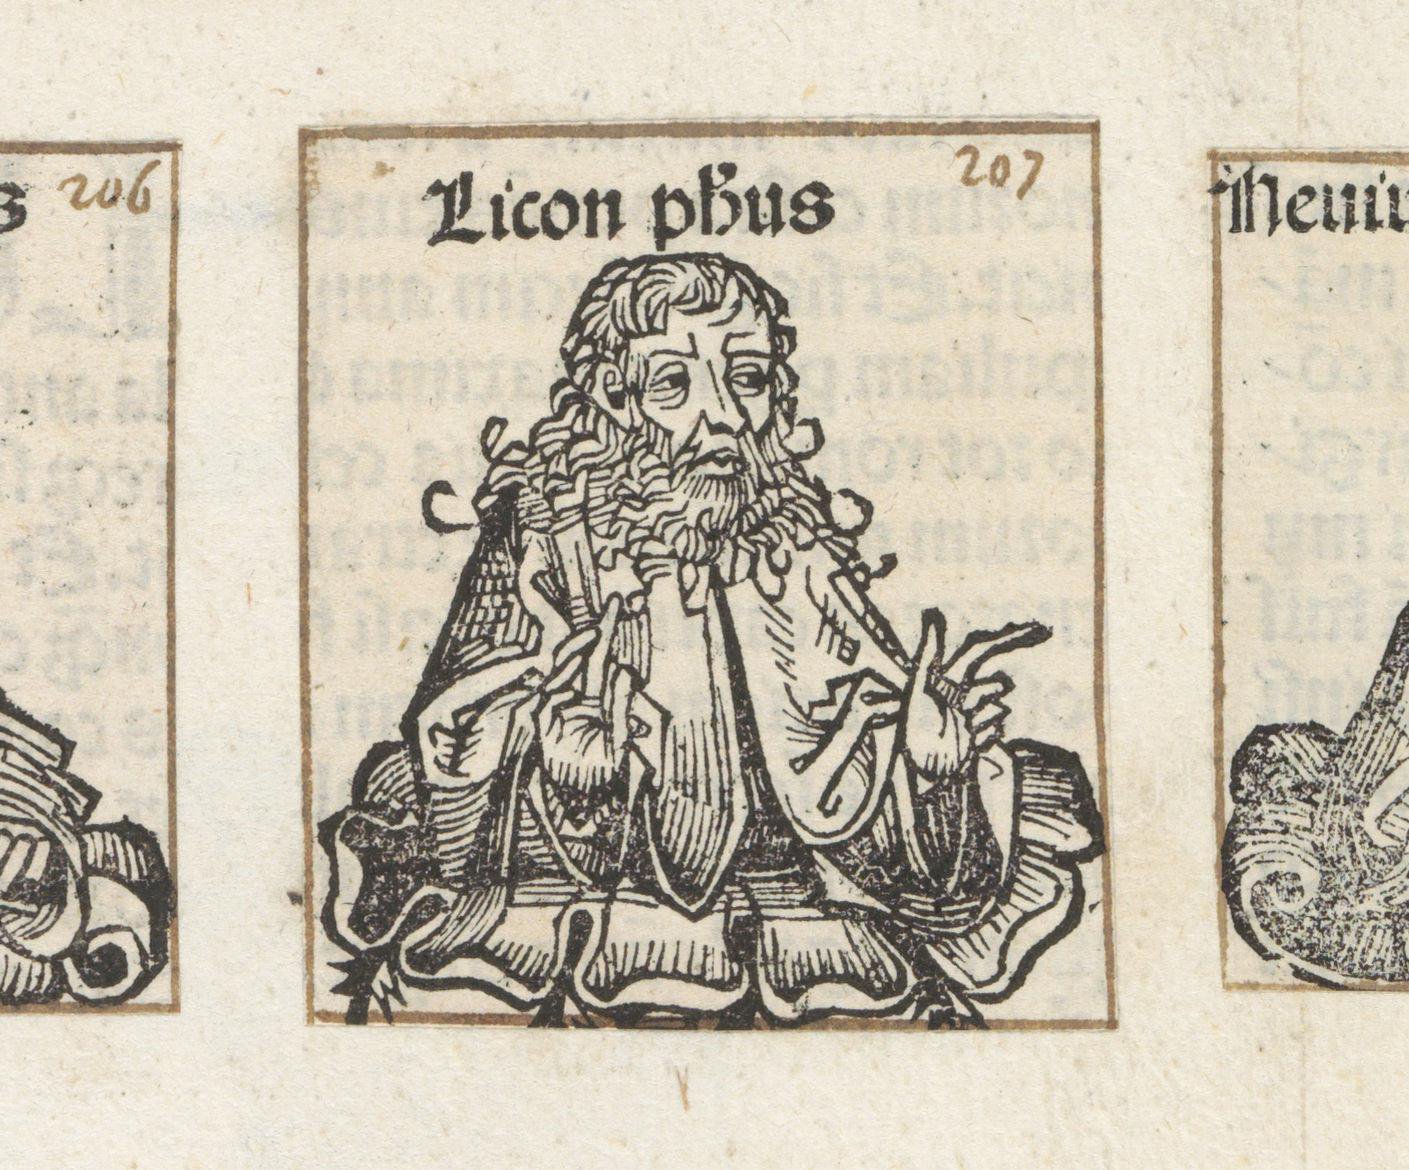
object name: print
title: Lyco van Troas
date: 1493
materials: paper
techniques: letterpress printing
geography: nuremberg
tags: male persons from classical history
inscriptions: inscription: ‘207’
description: De houtsnede wordt gebruikt als boekillustratie in de Liber Chronicarum (of Neurenbergkroniek) van Hartmann Schedel, verschenen in het Latijn en Duits in 1493. Zie de Latijnse uitgave, folio 82v.